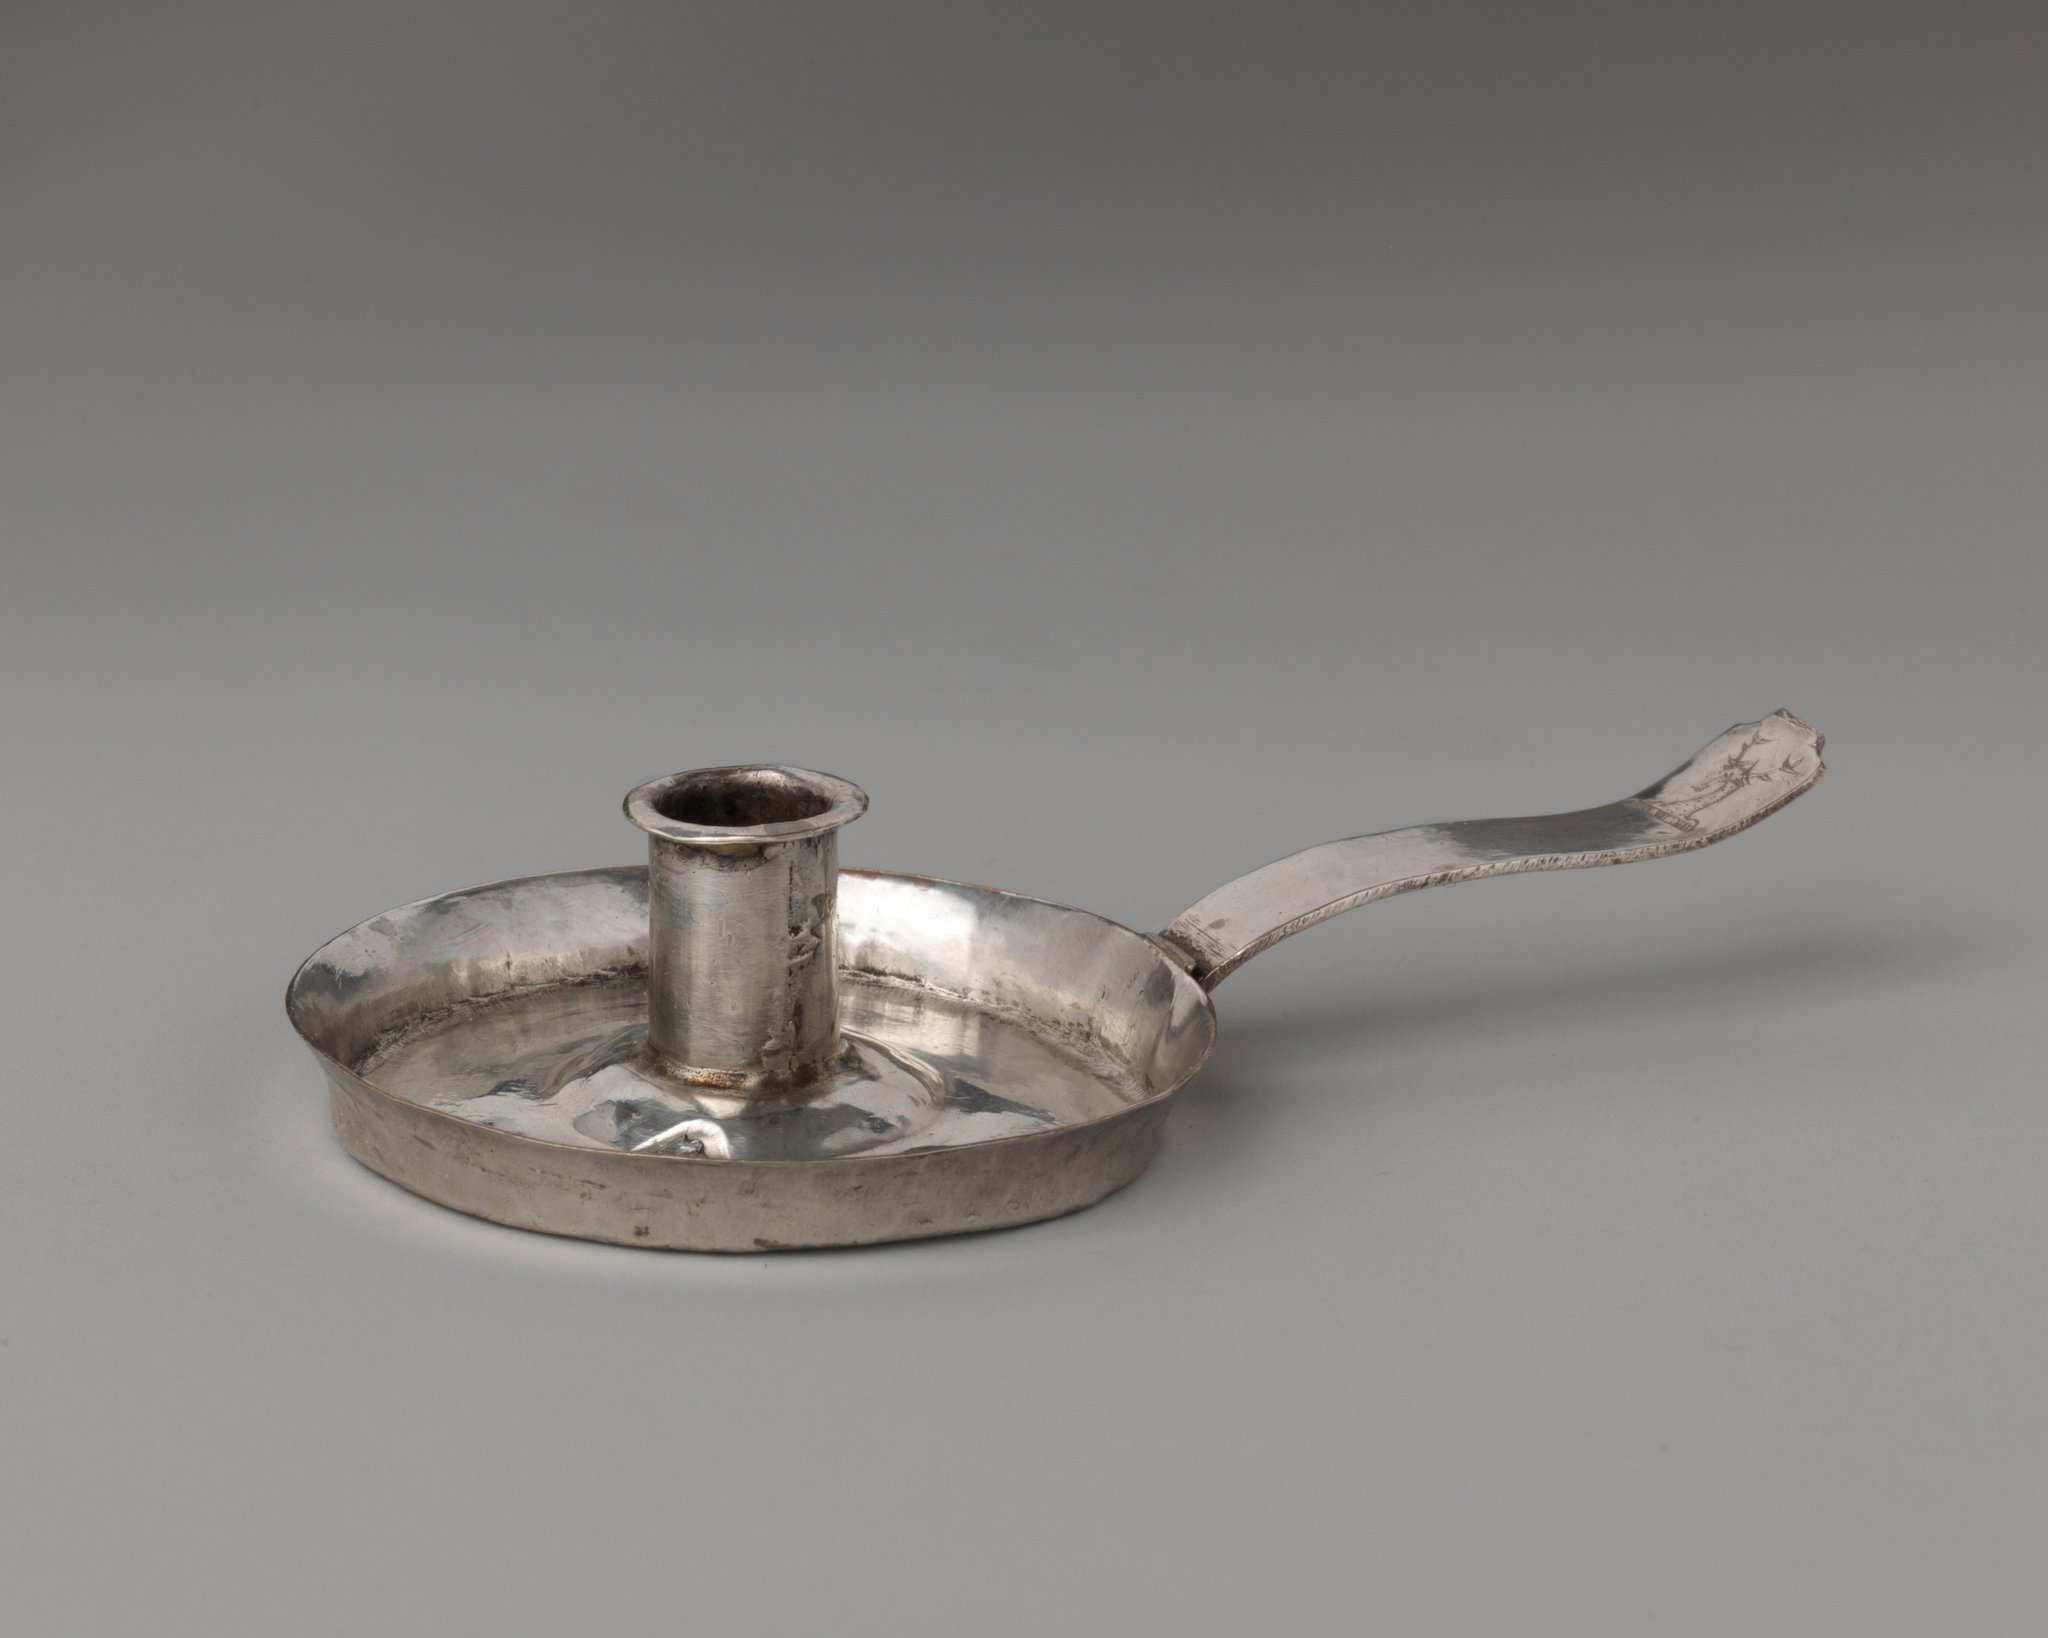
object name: chamber candlestick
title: Miniature chamber candlestick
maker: george middleton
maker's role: maker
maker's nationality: british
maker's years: 1660-1745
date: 1685-1690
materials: silver